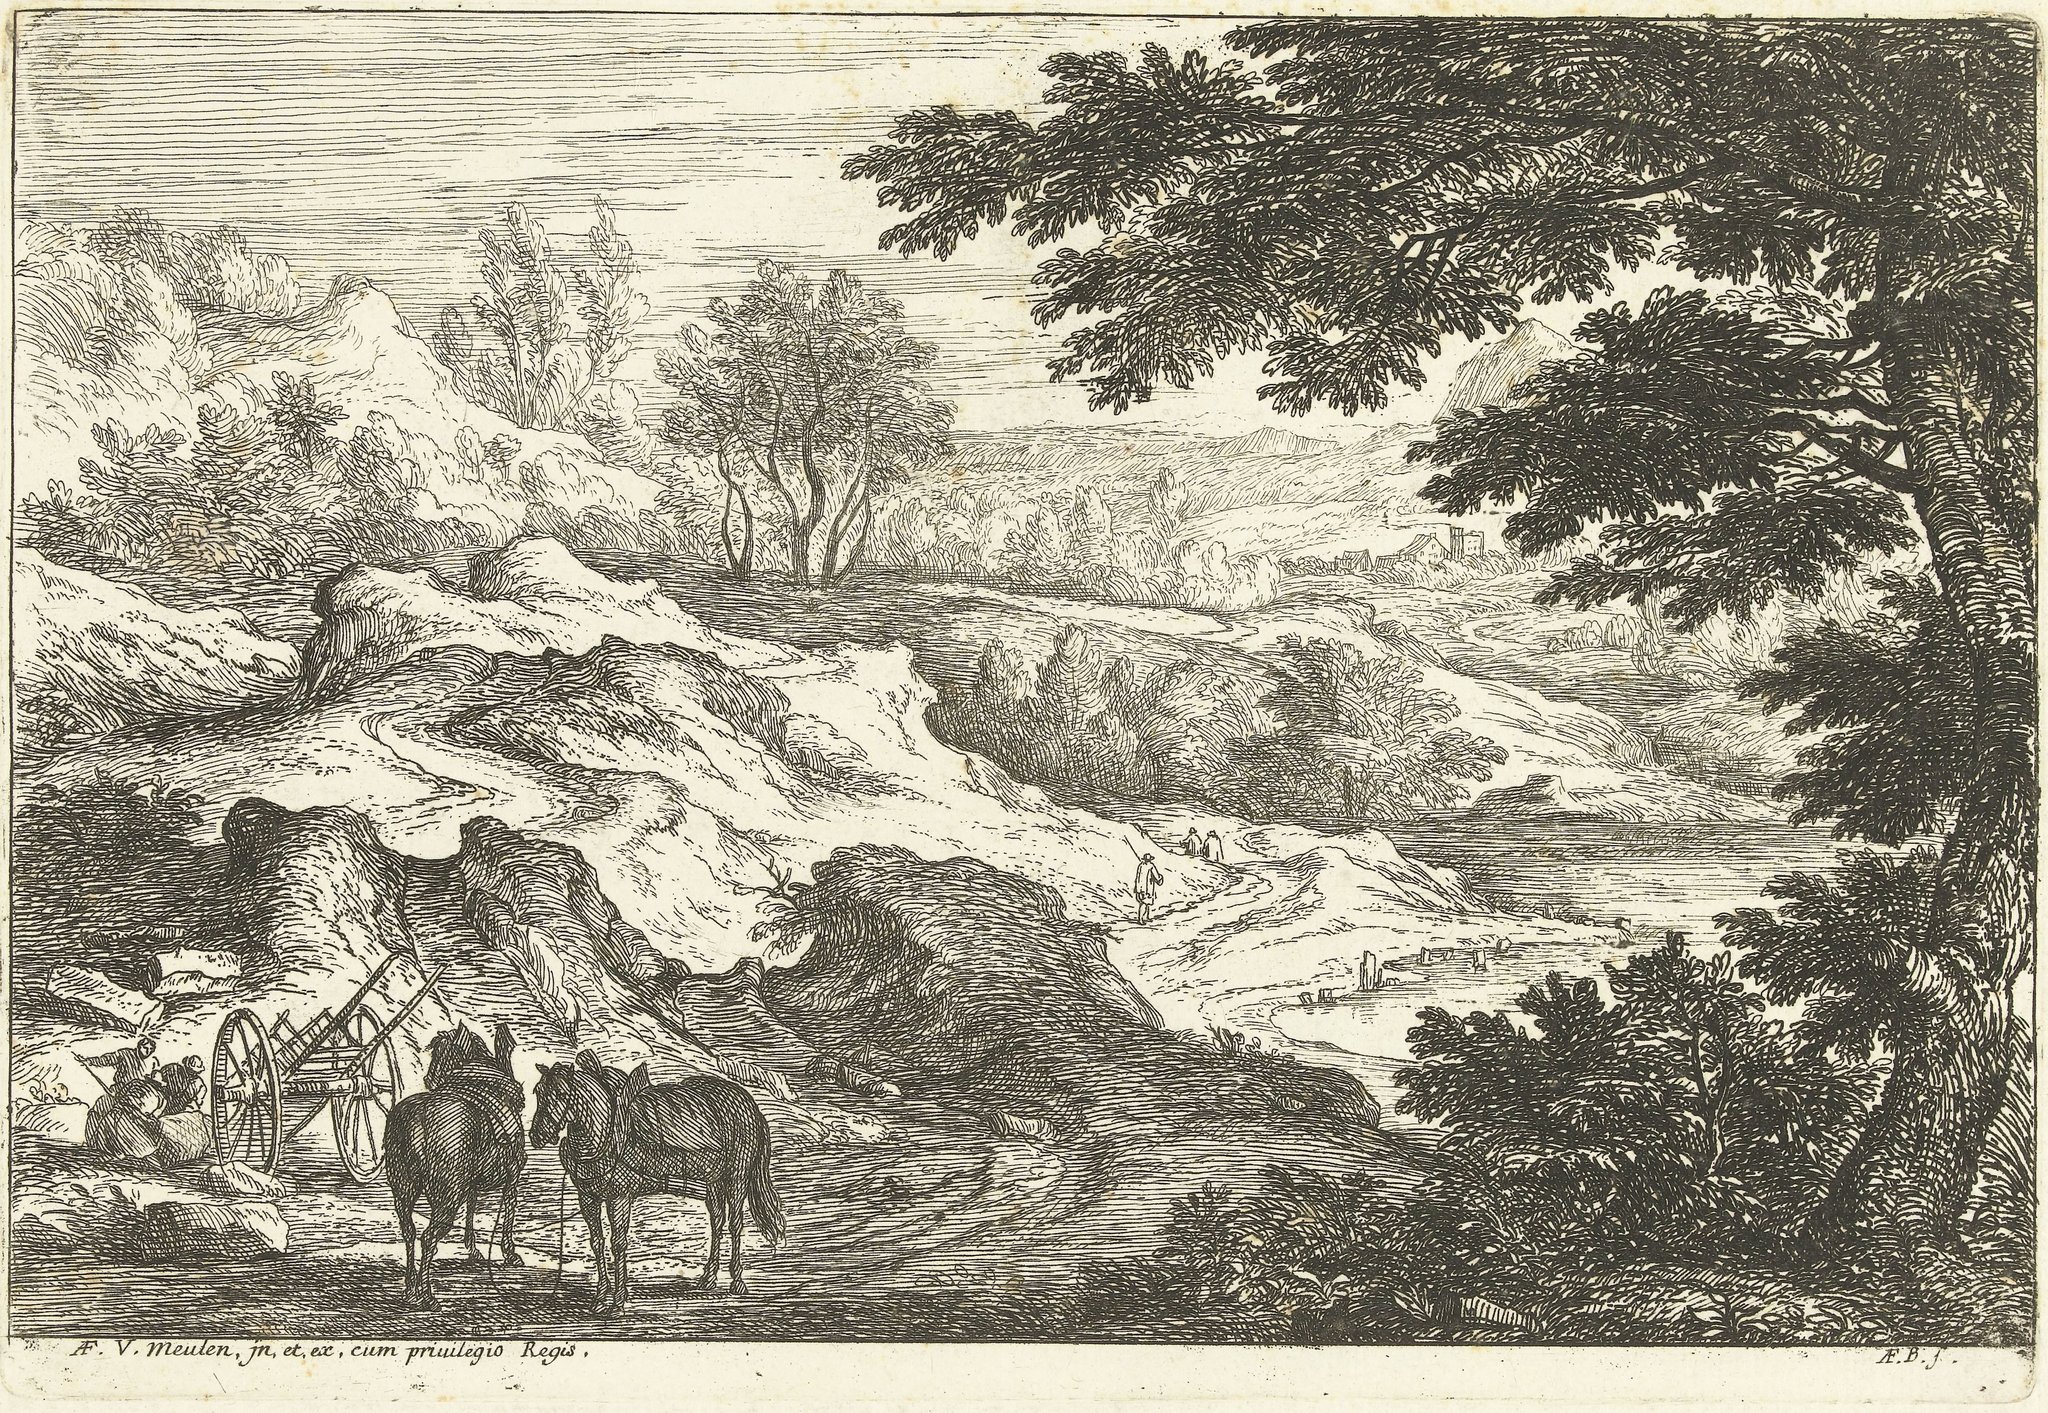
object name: print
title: Landschap met links twee paarden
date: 1666-1681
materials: paper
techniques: etching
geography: paris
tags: landscapes in the temperate zone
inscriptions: collector's mark: Lugt 240